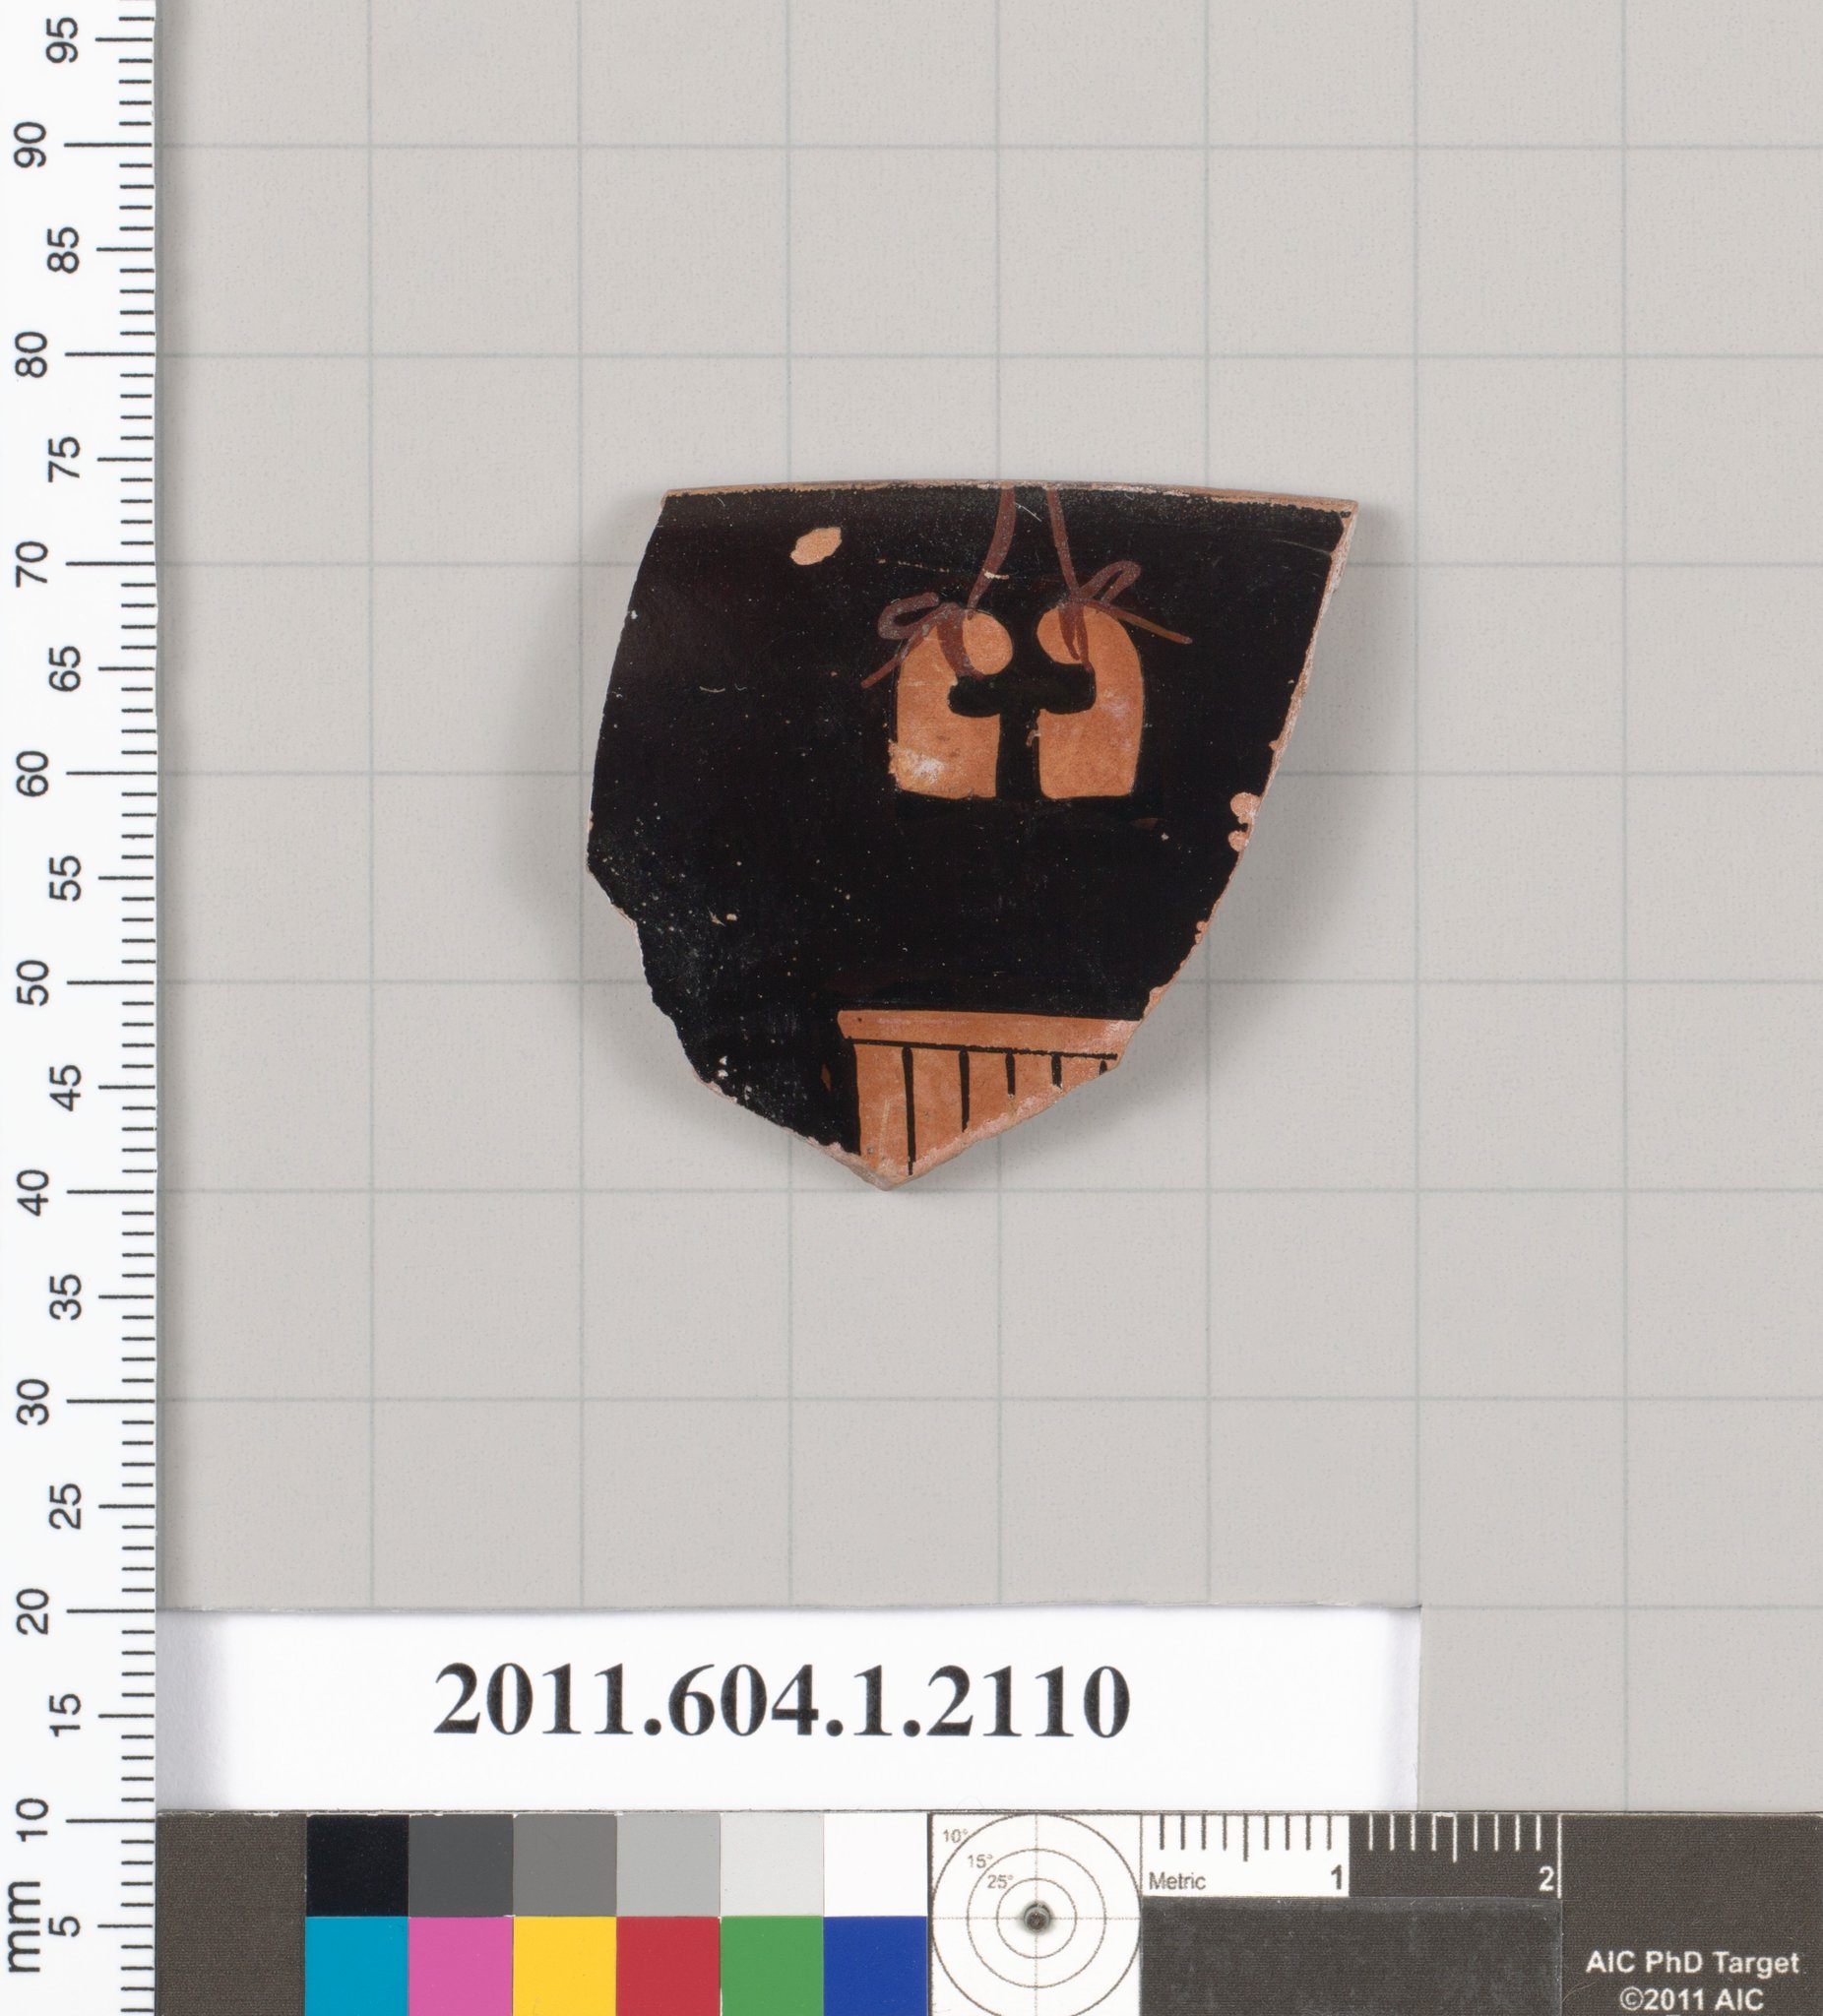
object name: kylix fragment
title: Terracotta rim fragment of a kylix (drinking cup)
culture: greek, attic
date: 490-480 BCE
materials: terracotta